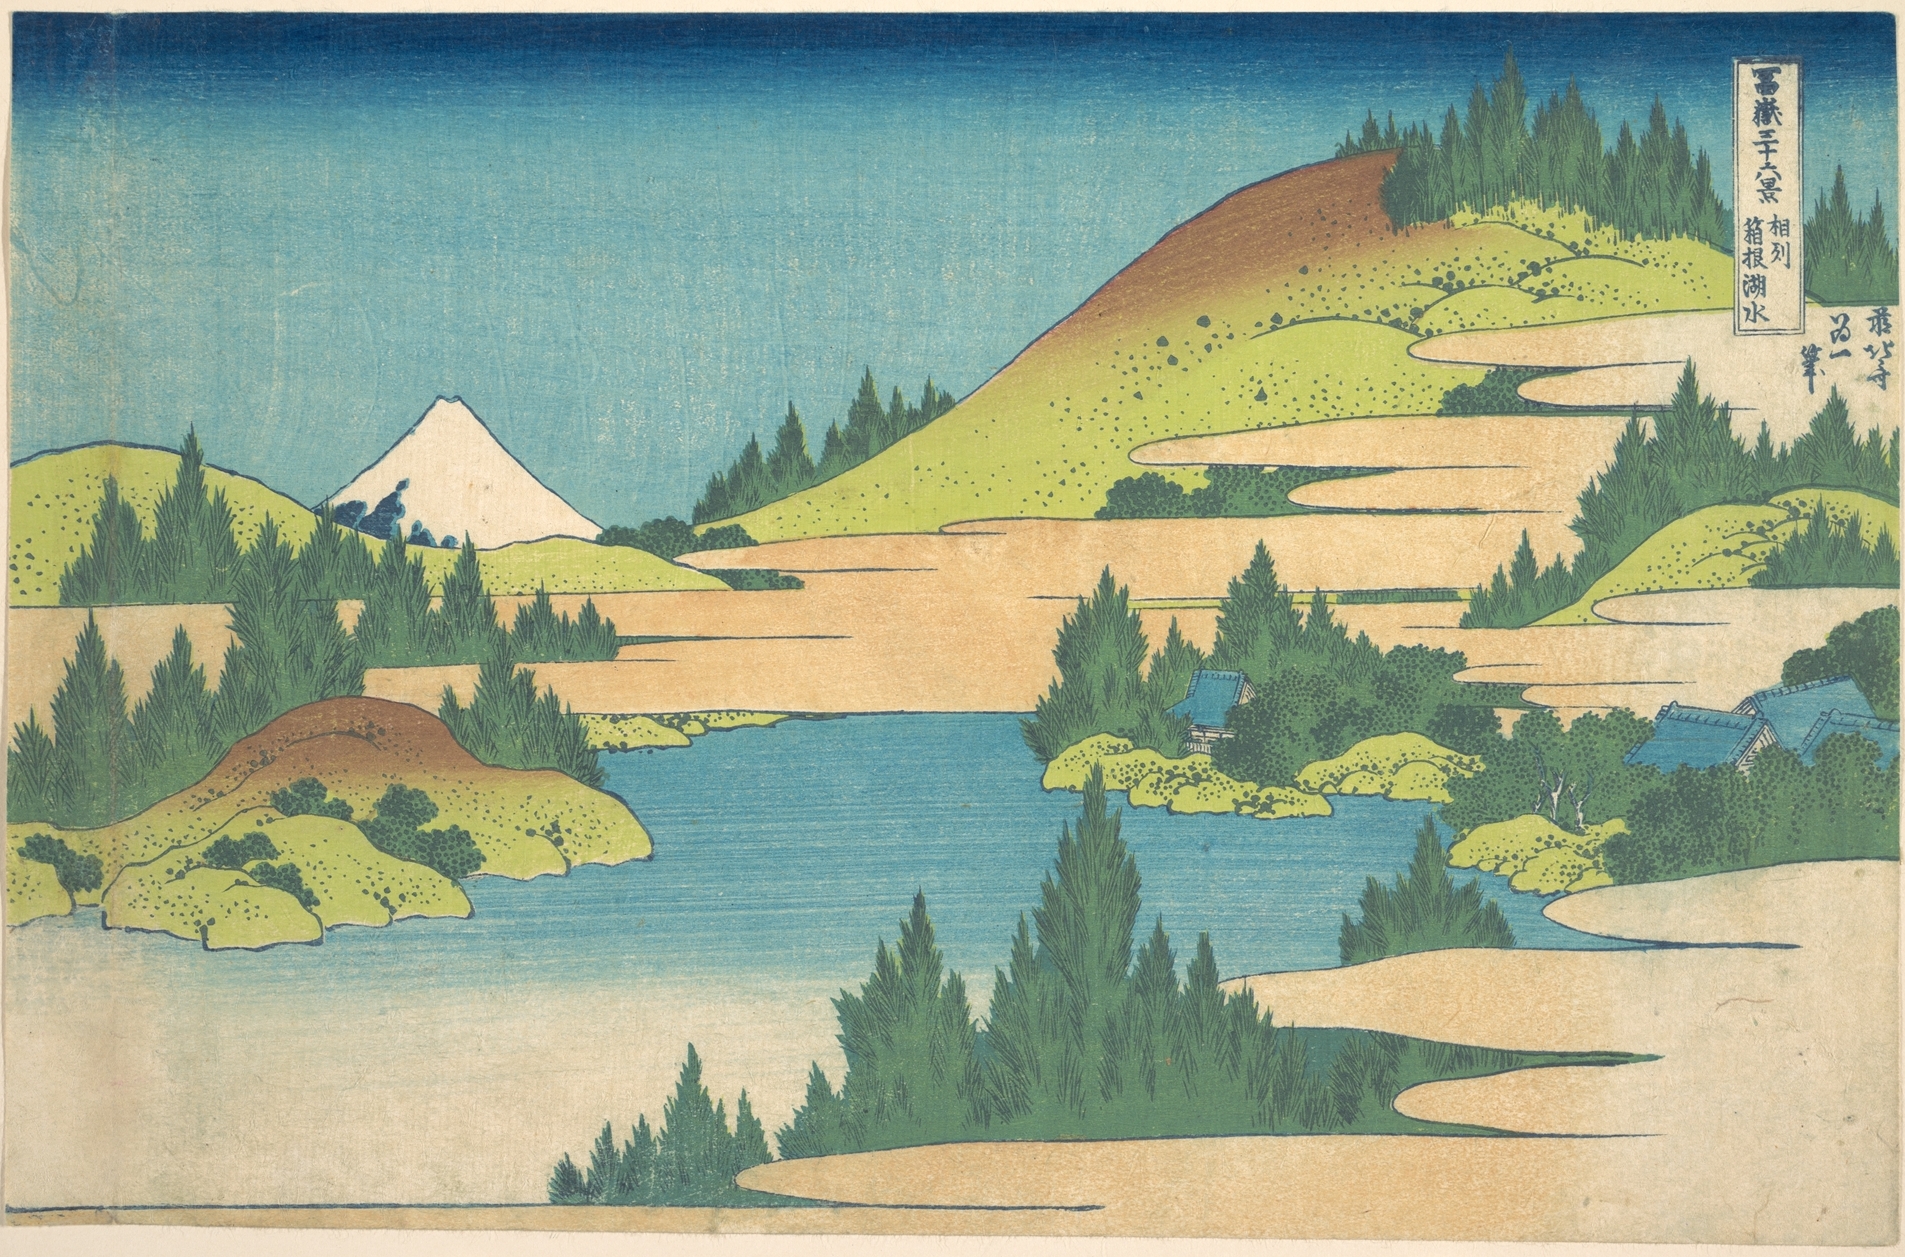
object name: woodblock print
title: The Lake at Hakone in Sagami Province (Sōshū Hakone kosui), from the series Thirty-six Views of Mount Fuji (Fugaku sanjūrokkei)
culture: japanese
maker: katsushika hokusai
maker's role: artist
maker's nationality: japanese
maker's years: 1760-1849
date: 1830-1832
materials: ink, paper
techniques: woodblock print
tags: lakes,mountains,landscapes,trees